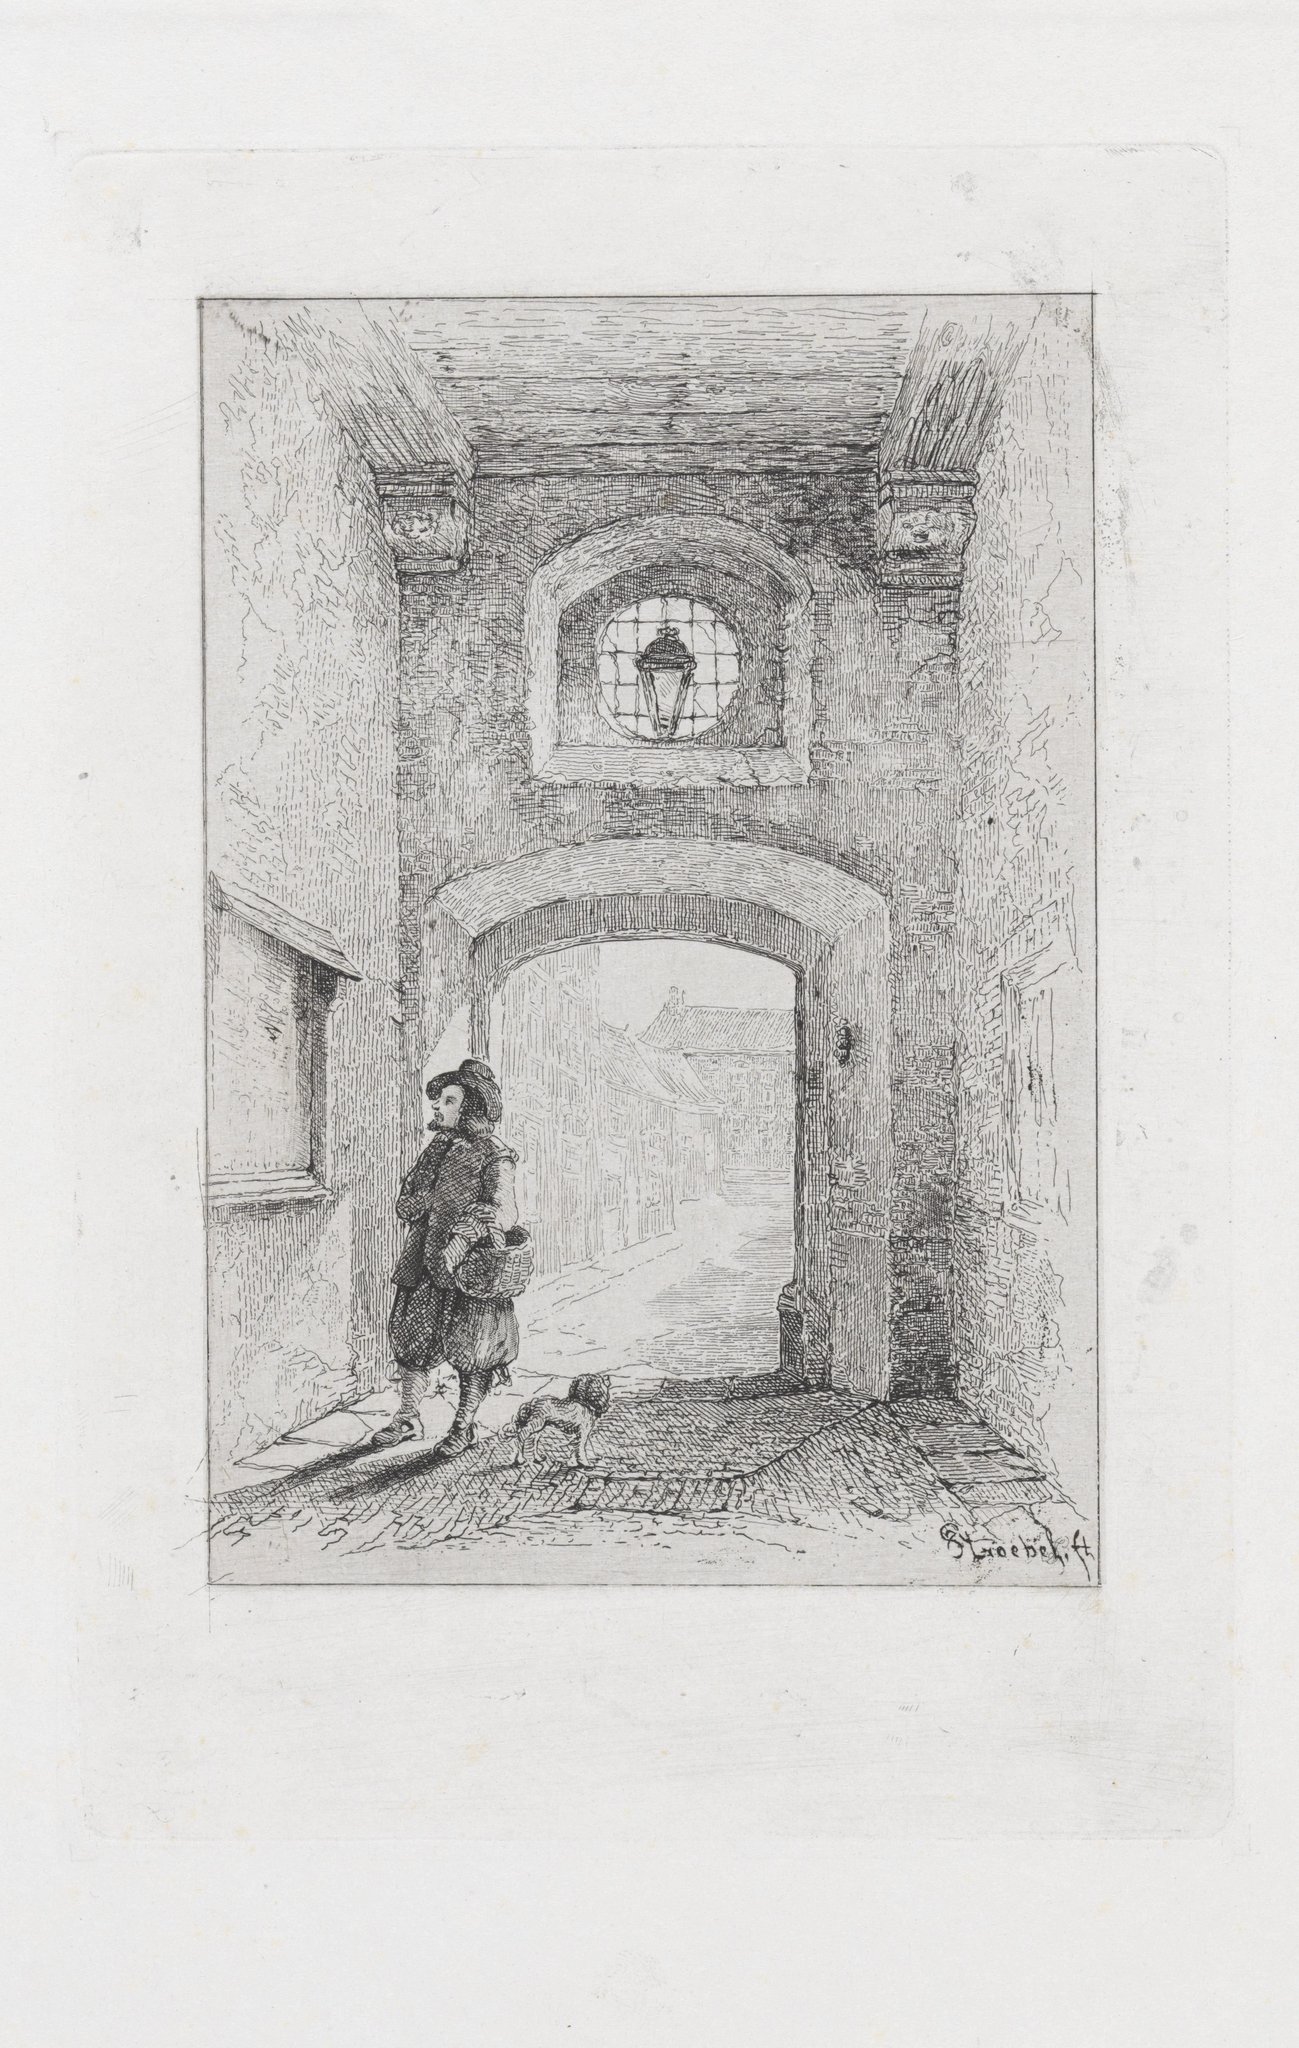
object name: print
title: Man met hond bij een poort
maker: johannes stroebel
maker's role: draughtsman, painter, print maker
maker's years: 1821-1905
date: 1831-1905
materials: paper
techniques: engraving, etching, roulette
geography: netherlands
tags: gate, entrance, dog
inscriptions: collector's mark: Lugt 2760, collector's mark: Lugt 2228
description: Links staat een man met een mand aan zijn arm een aanplakbord te lezen. Naast hem een hondje. Boven de poort een raam en een lantaarn.